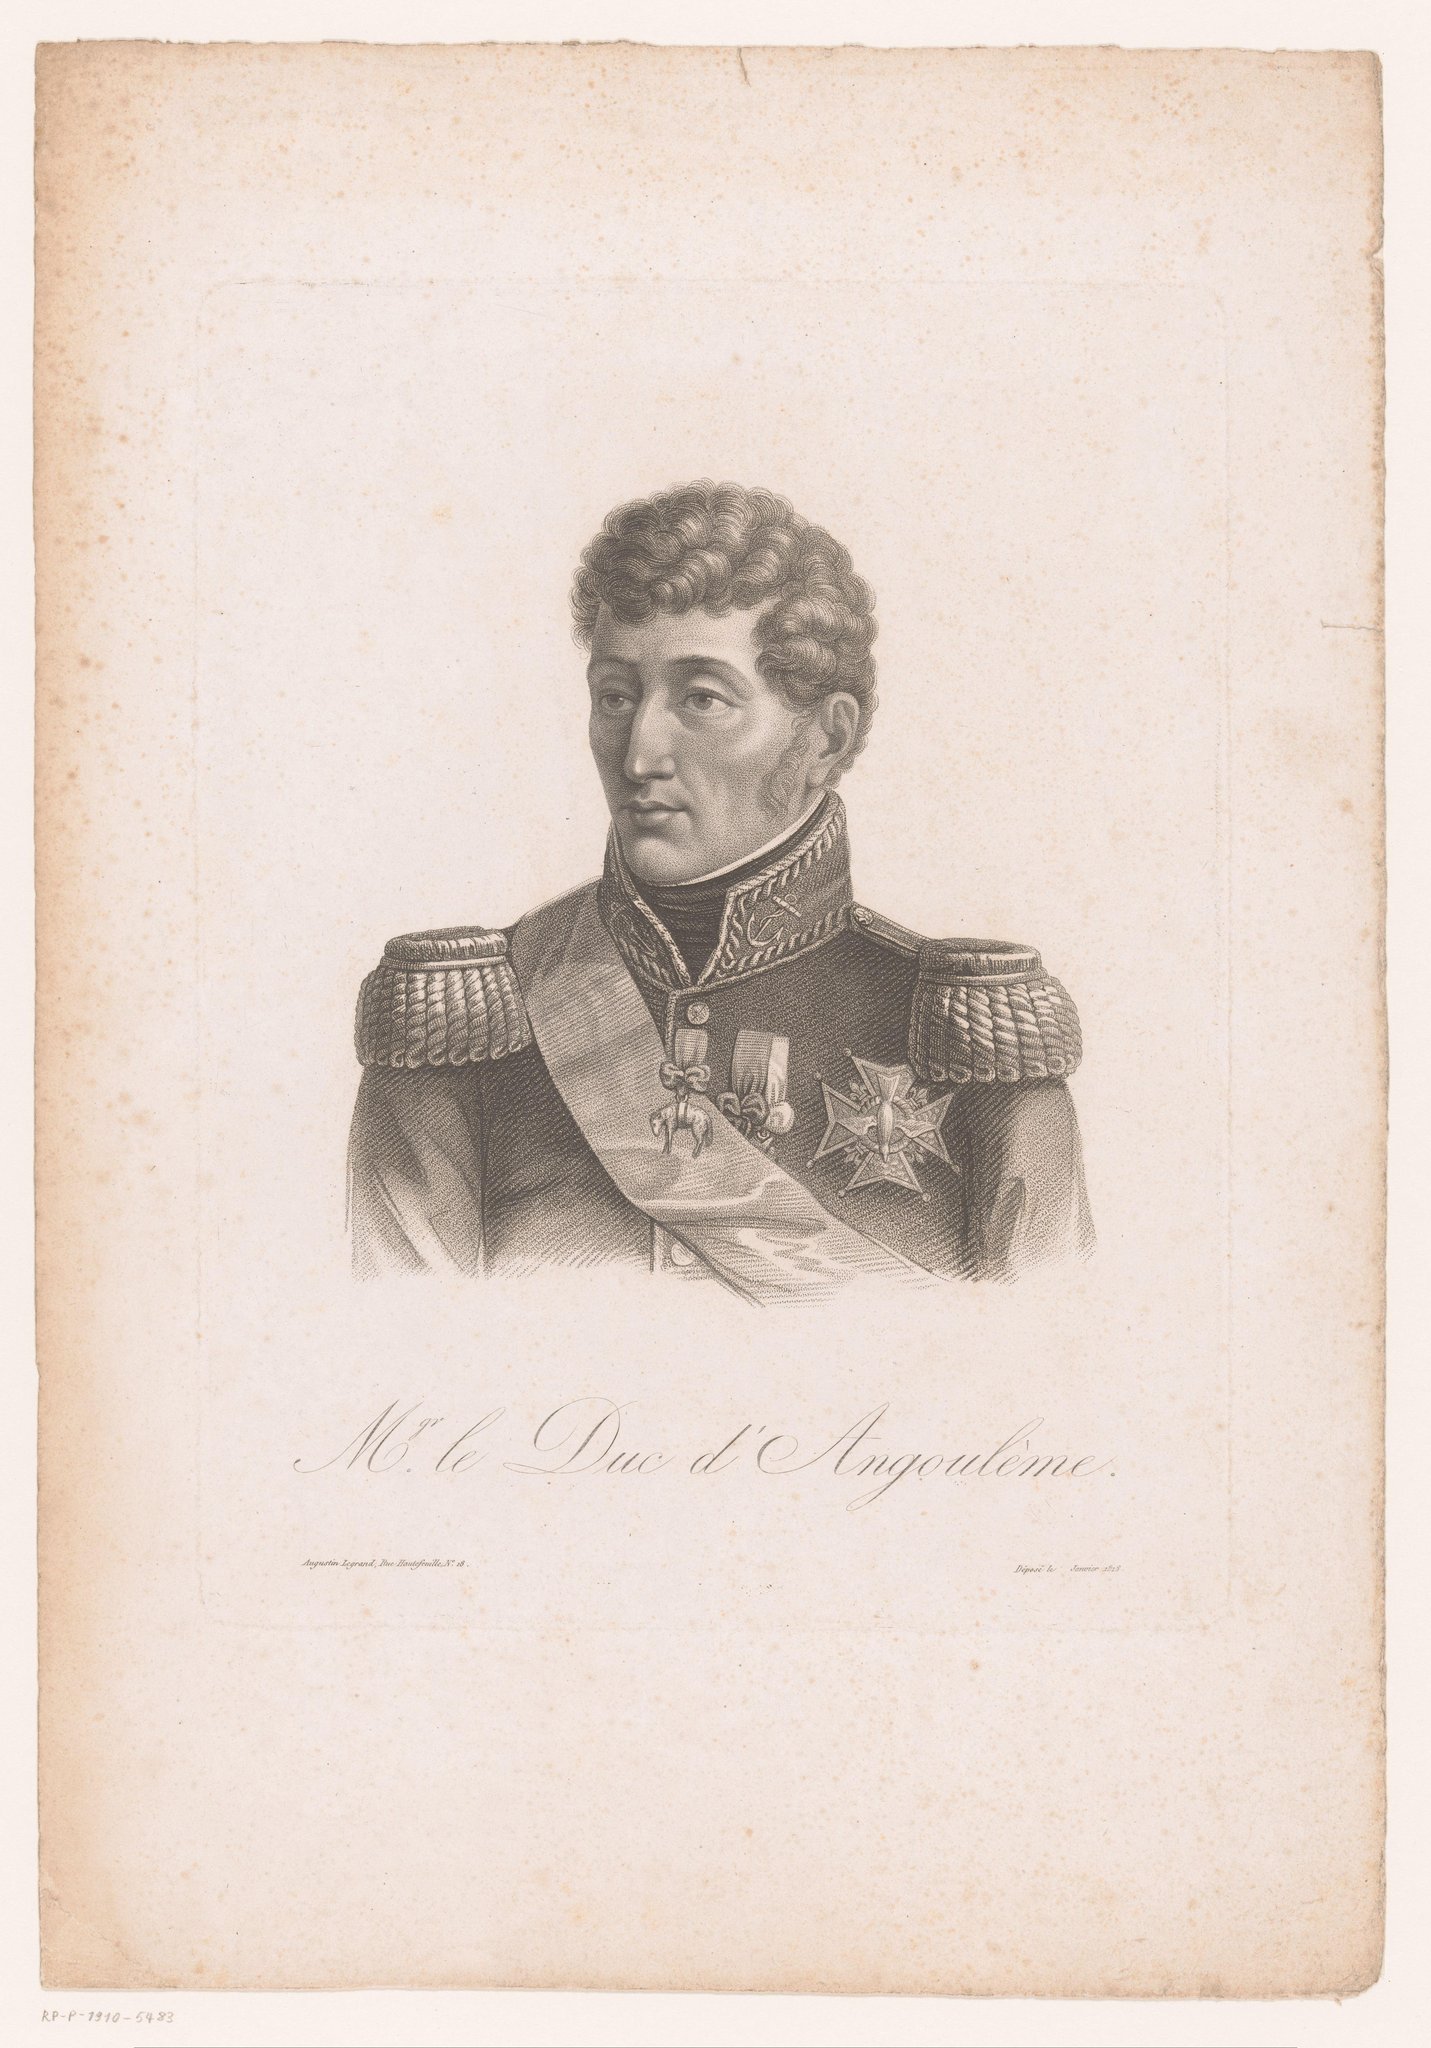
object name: print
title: Portretten naar Vauthier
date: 1815-1817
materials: paper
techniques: engraving, etching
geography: france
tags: historical persons, nobility and patriciate; chivalry, knighthood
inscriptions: collector's mark: Lugt 2228, : ‘Déposé le Janvier 1816.’